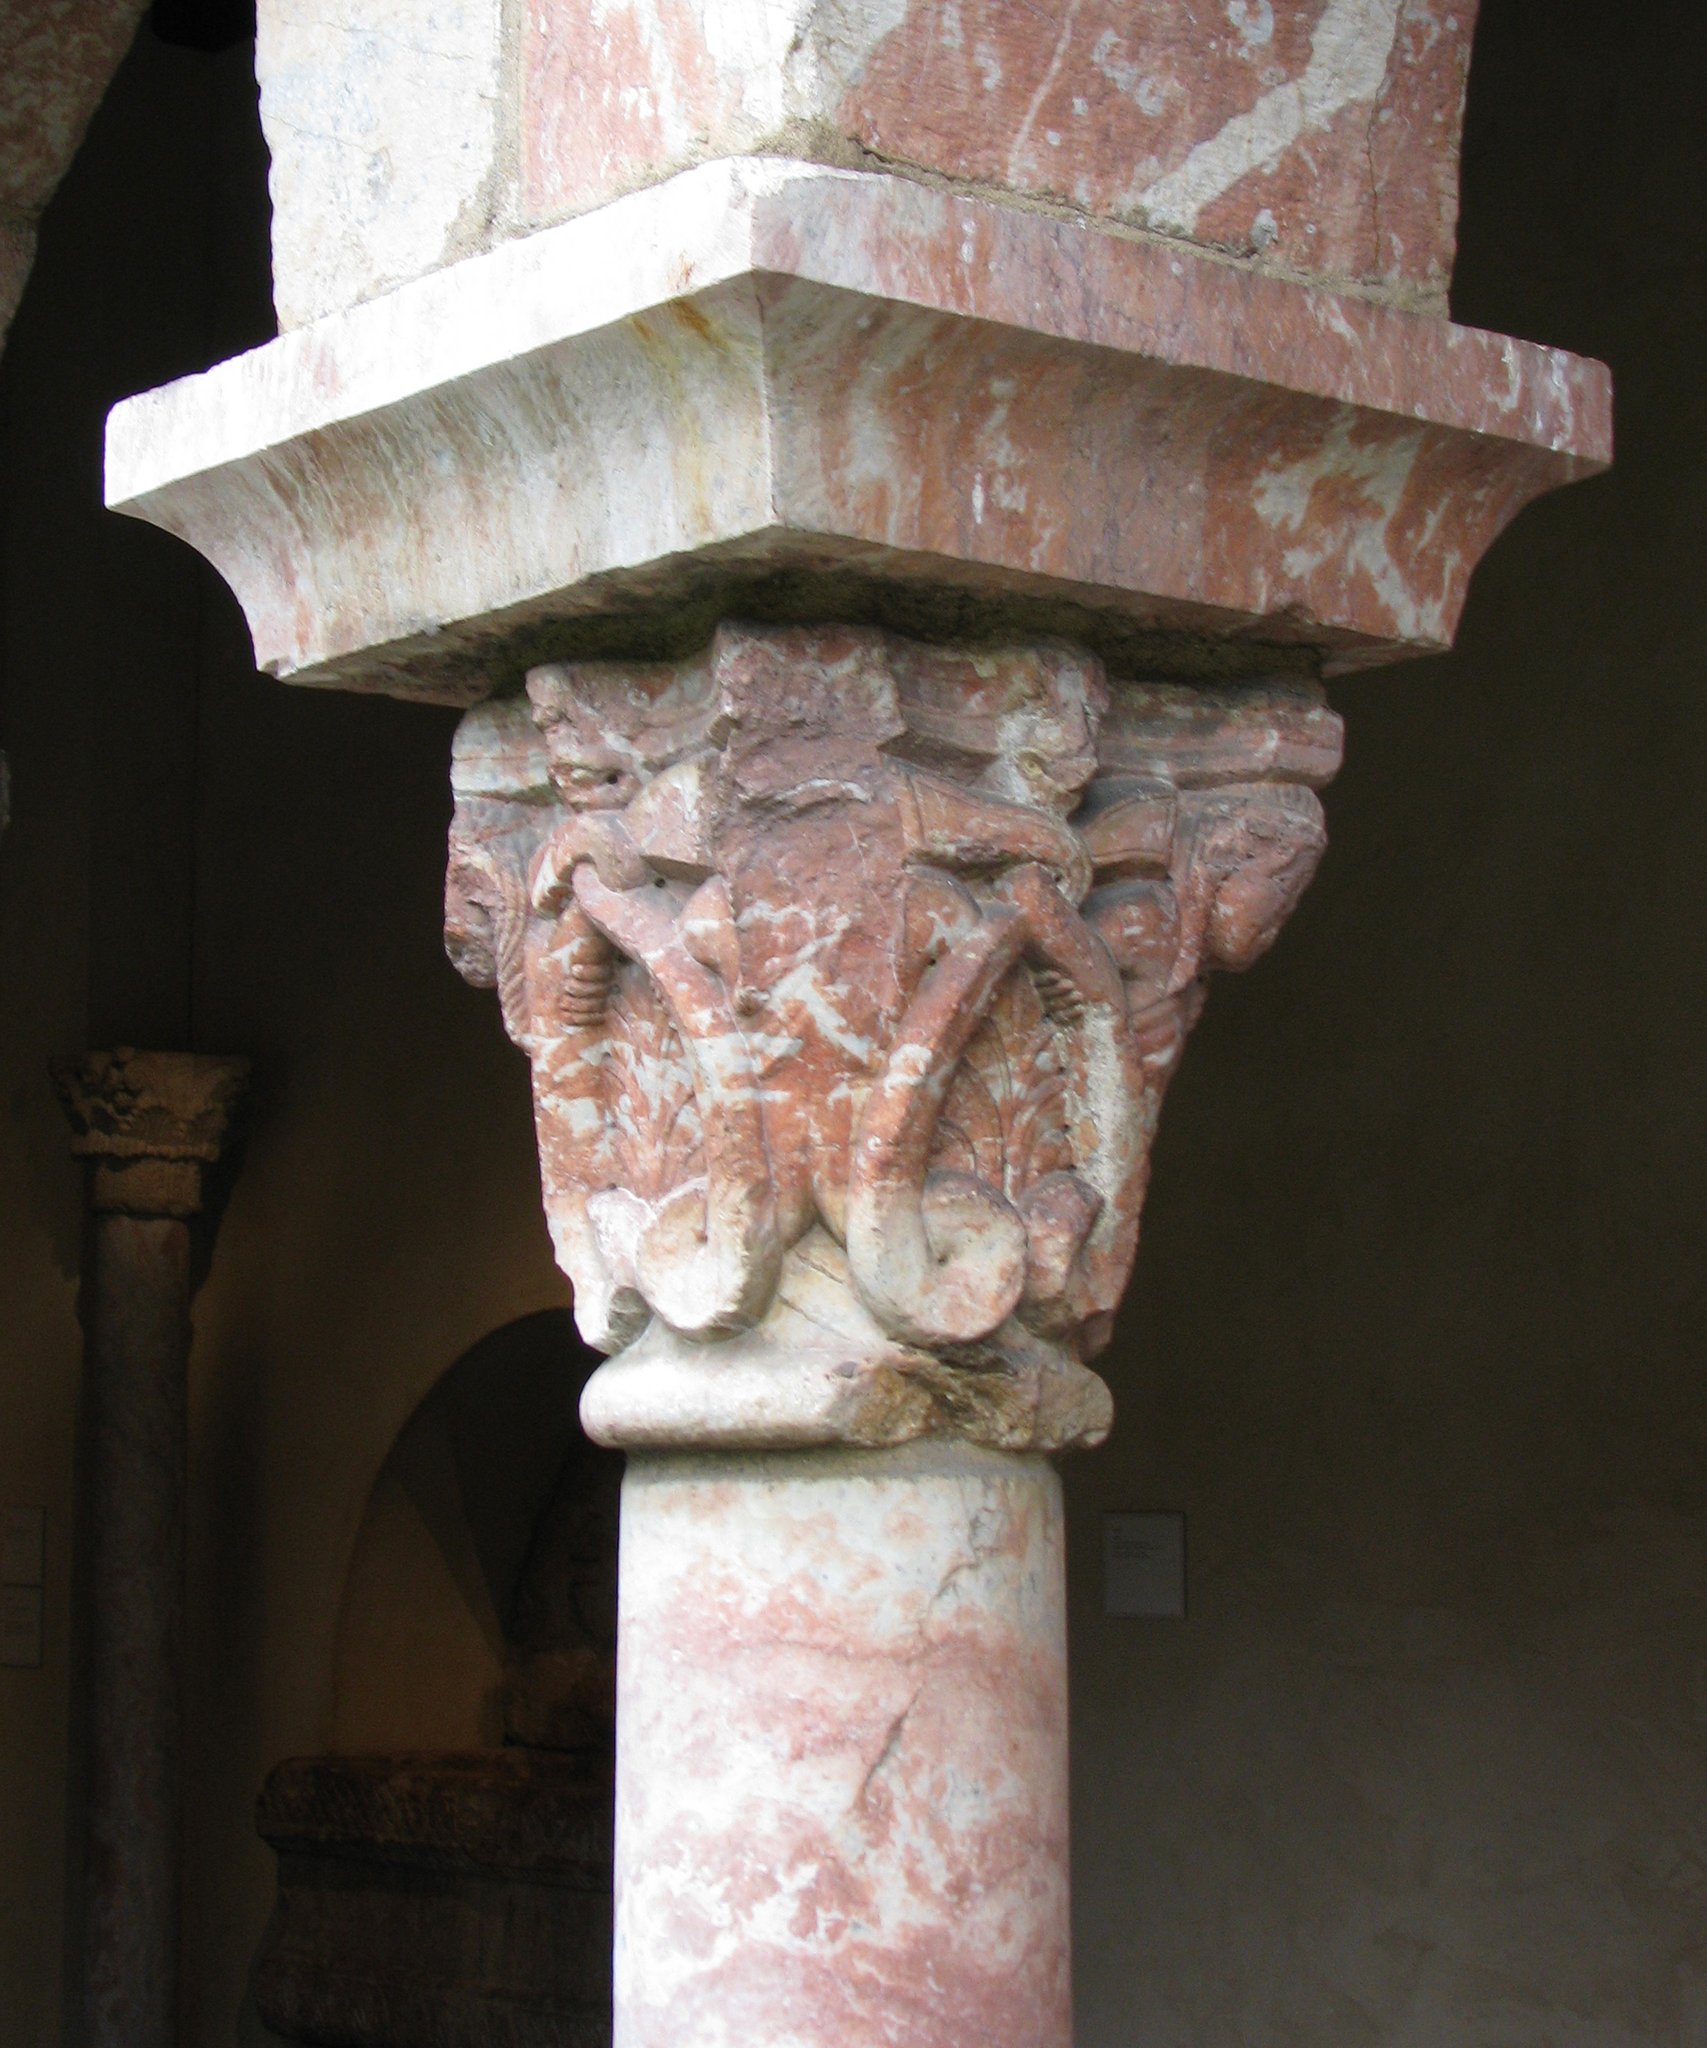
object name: capital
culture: catalan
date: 1140-1150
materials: marble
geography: france